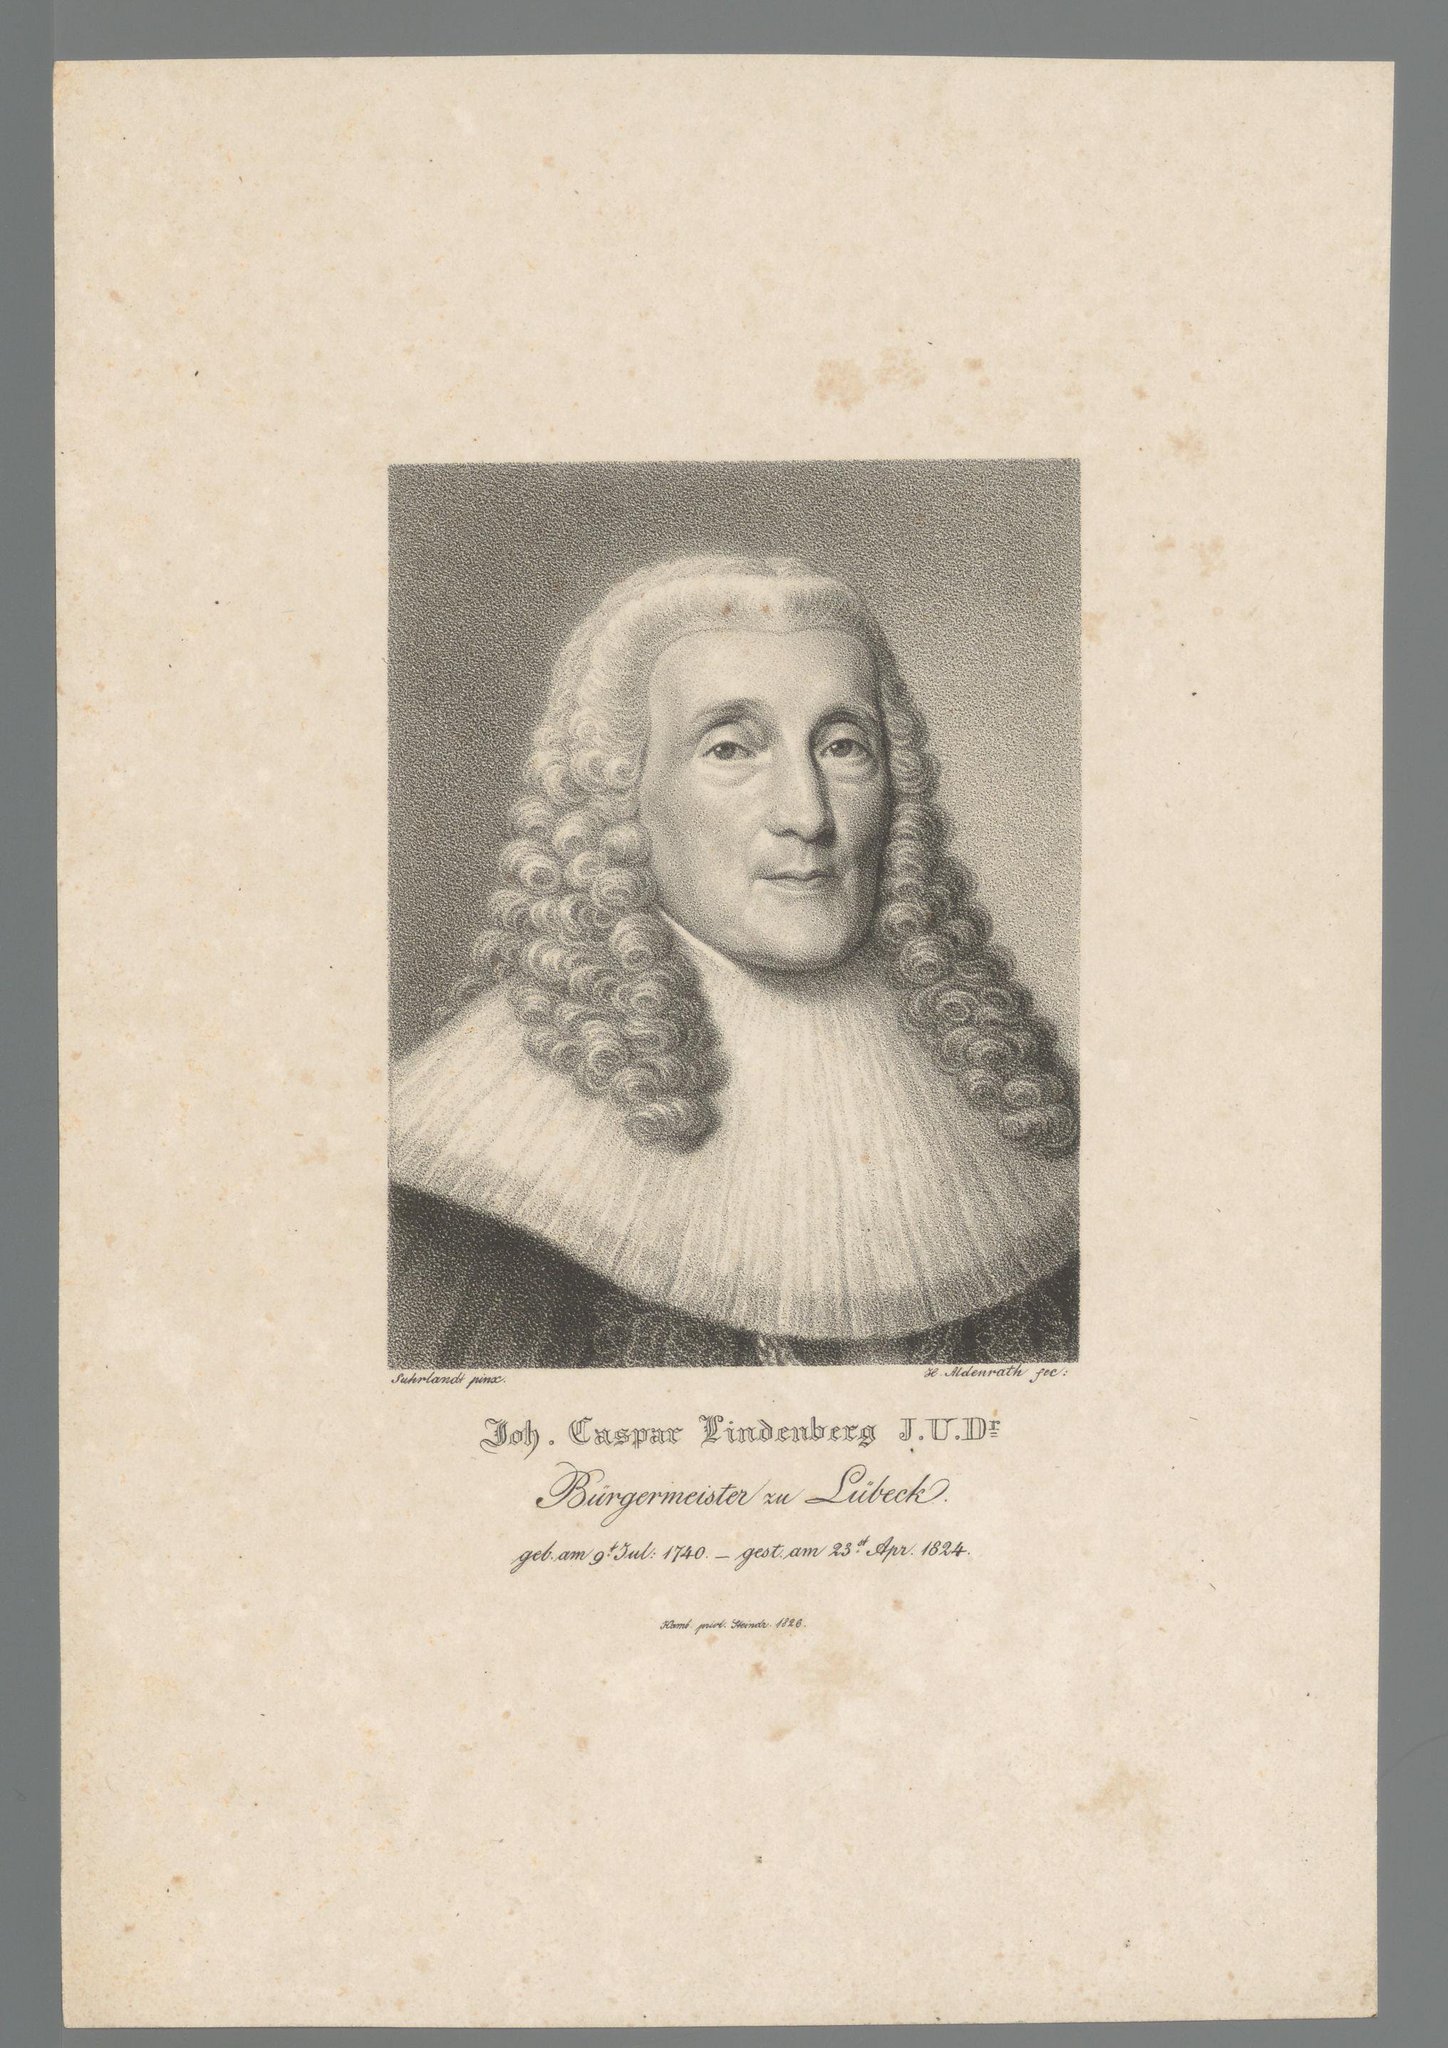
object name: print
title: Joh. Caspar Lindenberg J.U.Dr.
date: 1785-1844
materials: paper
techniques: lithograph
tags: mayor, burgomaster, historical persons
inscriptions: collector's mark: Lugt 2228